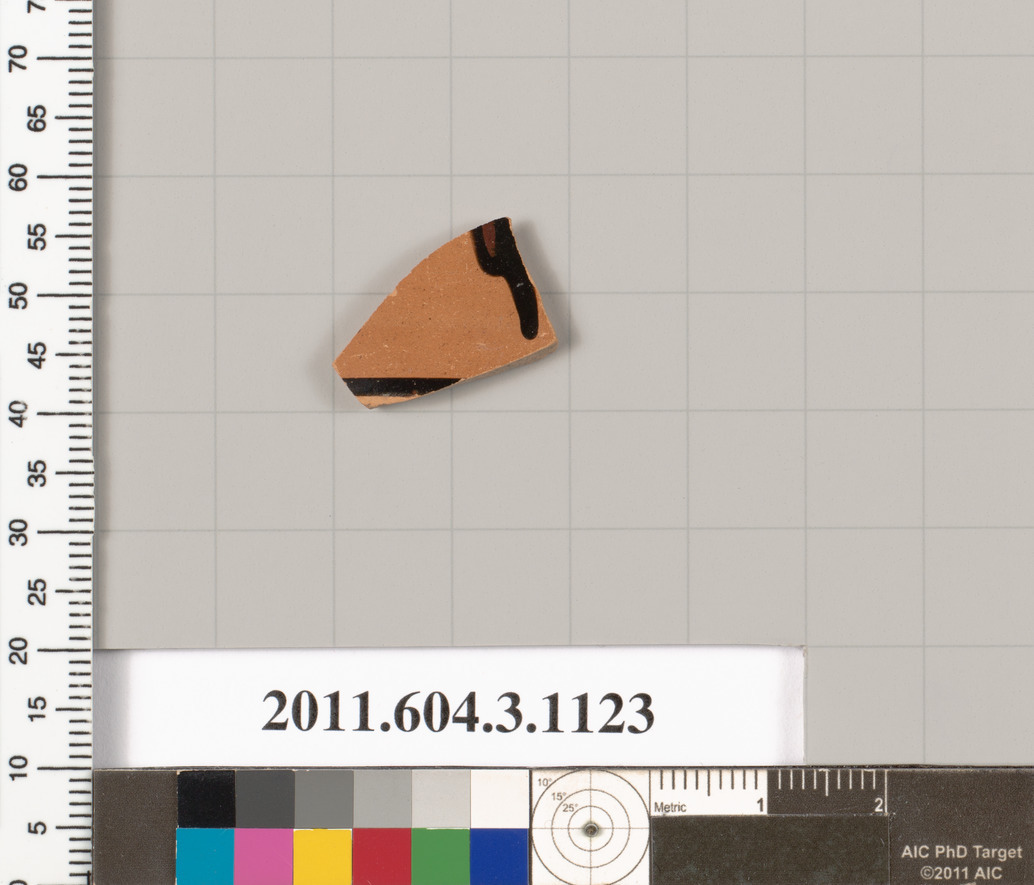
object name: mastoid or kyathos fragment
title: Terracotta fragment of a mastoid (drinking cup with narrow base) or a kyathos (cup-shaped ladle)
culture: greek, attic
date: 534-468 BCE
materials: terracotta